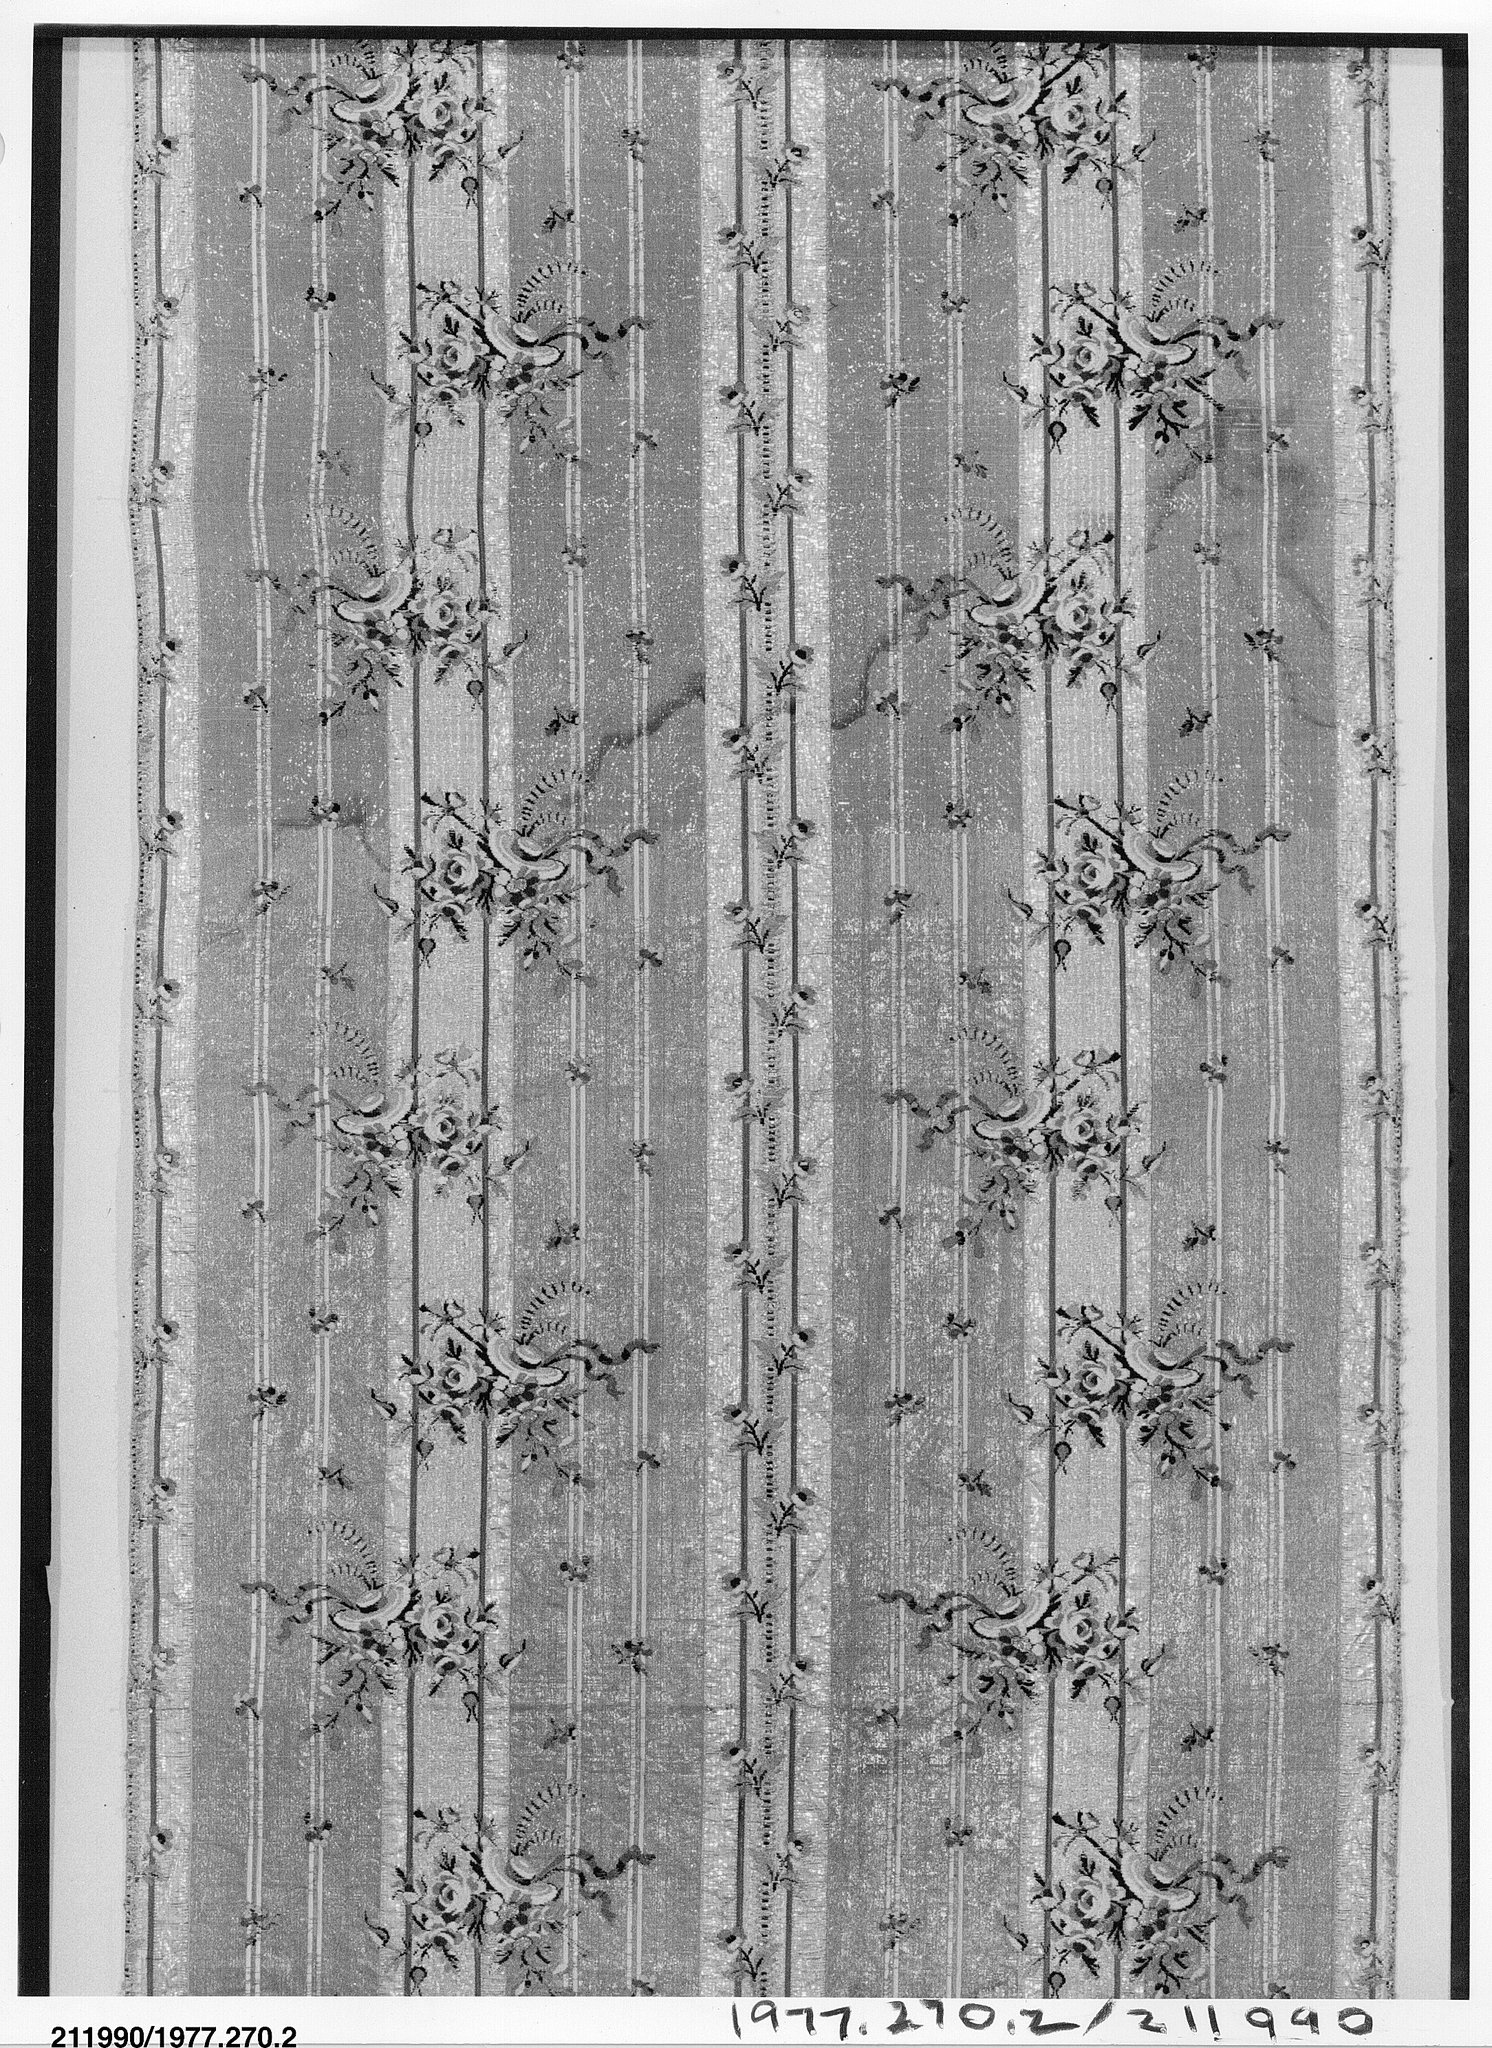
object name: panel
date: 1780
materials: metal thread, silk